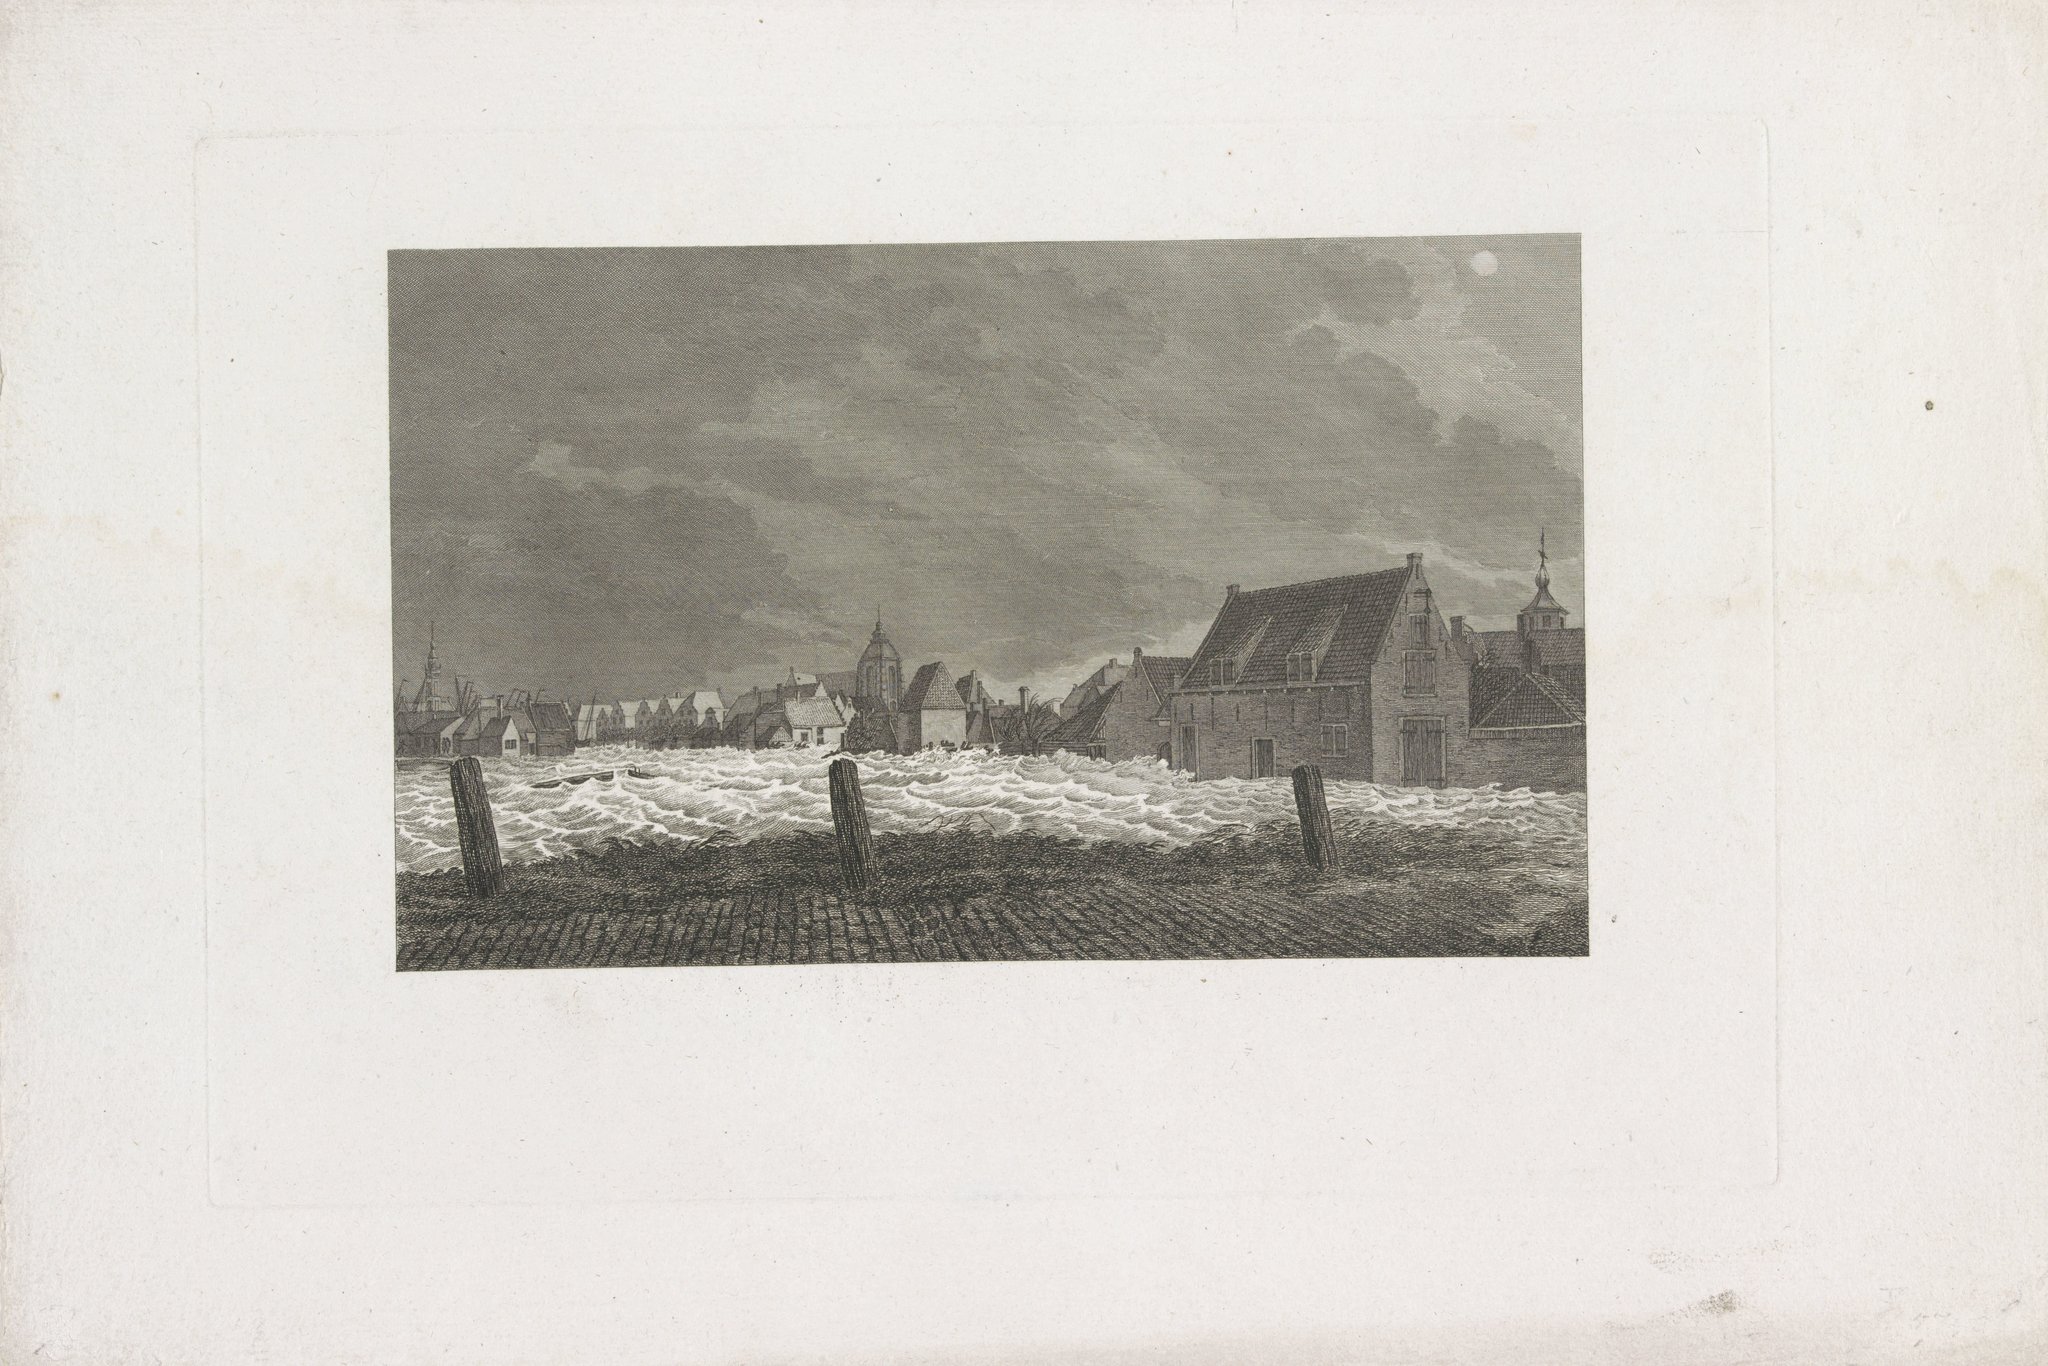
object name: print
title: Overstroming bij het Molenwater en de haven te Veere, 1808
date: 1808-1810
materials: paper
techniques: engraving, etching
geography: netherlands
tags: flood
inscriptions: collector's mark: Lugt 2228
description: Gebruikt als illustratie in: Sander van Hoek, Natuur- en geschiedkundige beschrijving van den verschrikkelijken watervloed tusschen den XIVden en XVden van louwmaand des jaars MDCCCVIII. 3 dln. Haarlem: Adriaan Loosjes Pz., 1808-1810.